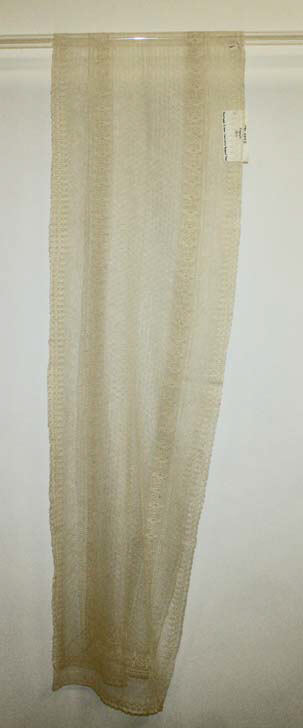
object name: stole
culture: french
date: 1810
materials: cotton